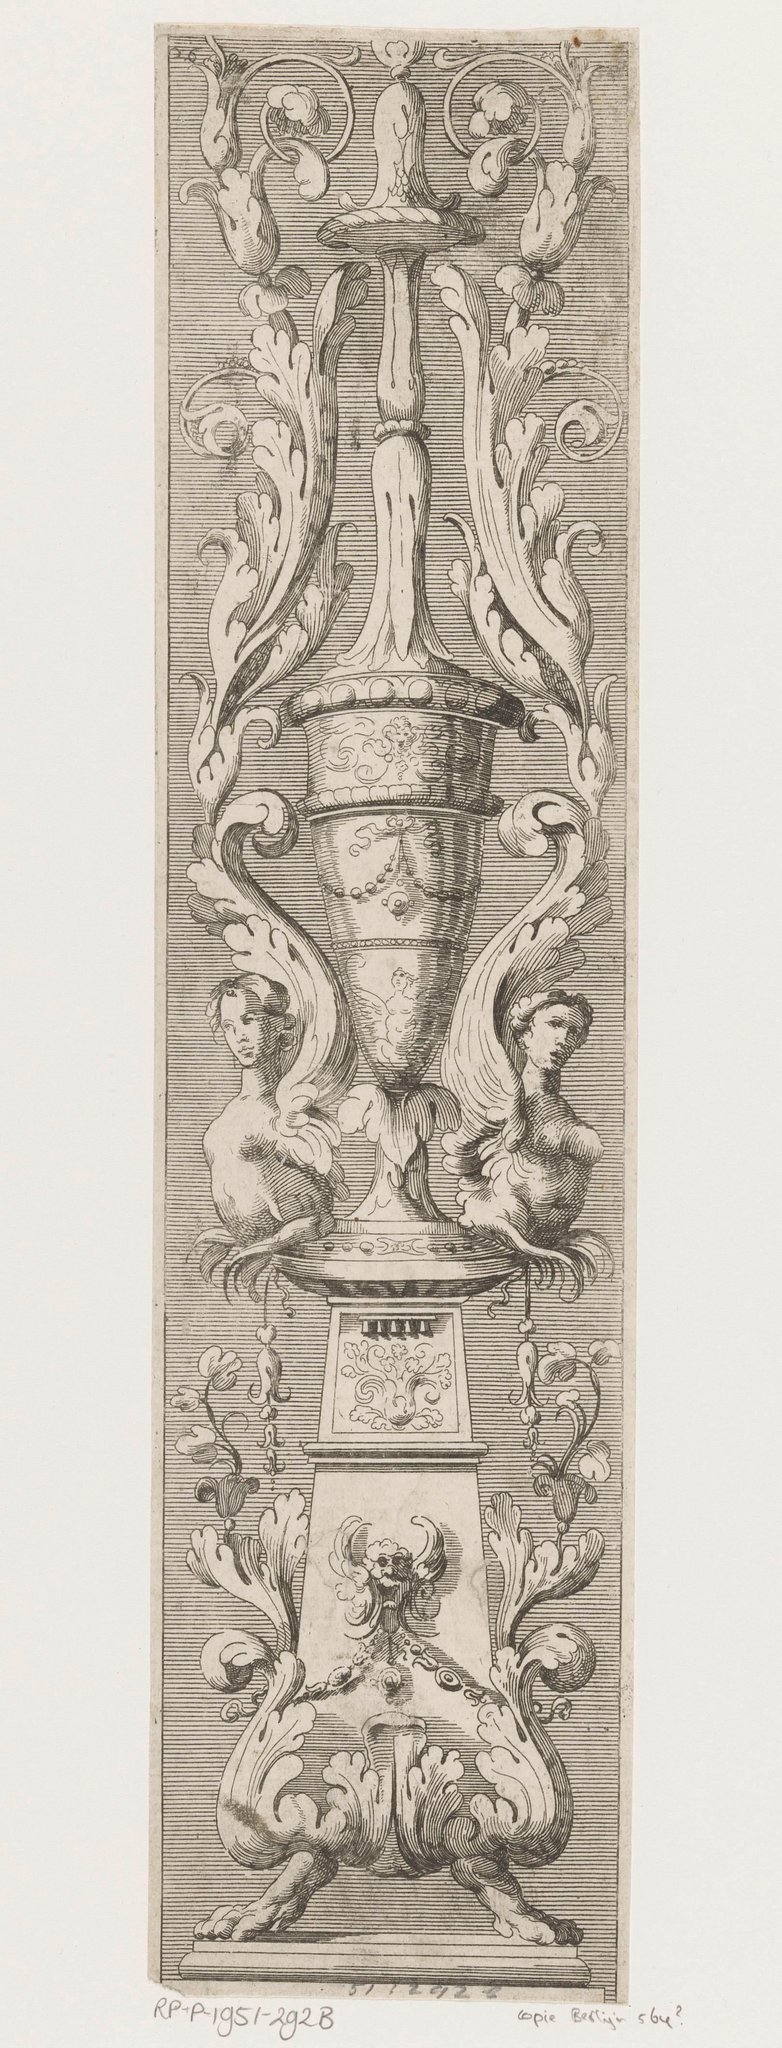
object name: print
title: Kandelaber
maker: Anonymous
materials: paper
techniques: etching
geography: italy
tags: ornament ~ candelabrum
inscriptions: collector's mark: Lugt 2228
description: Deze prent maakt deel uit van een reeks kopieën naar prenten van Agostino Mitelli. Mitelli maakte zijn prenten naar tekeningen van marmeren pilasterdecoraties van de poort van de S. Bartolomeo di Porta Ravegnana in Bologna.